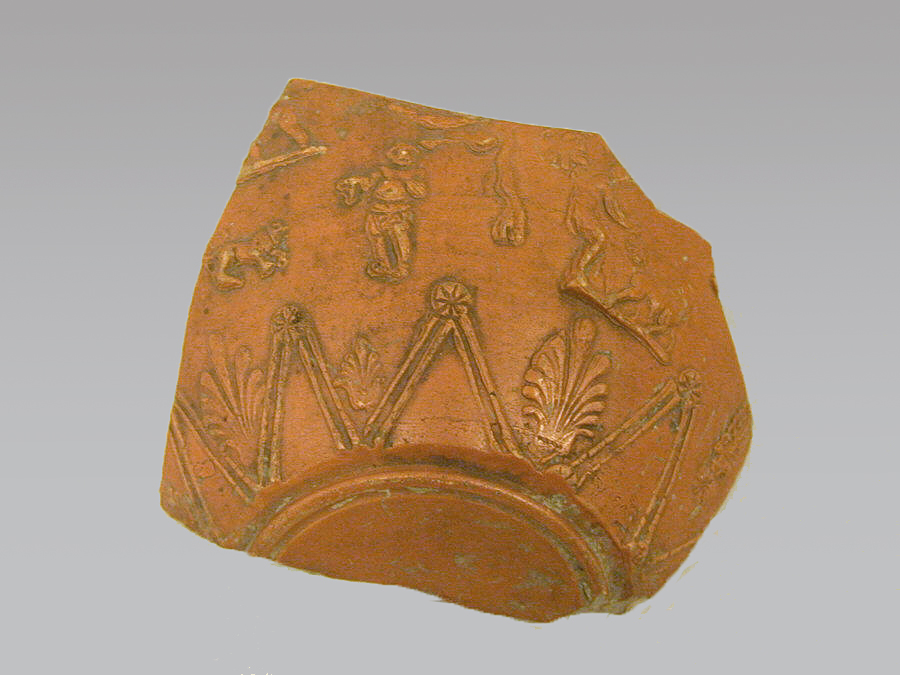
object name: vase fragment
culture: roman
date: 100 BCE-100 CE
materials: terracotta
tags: palmettes,men,lions